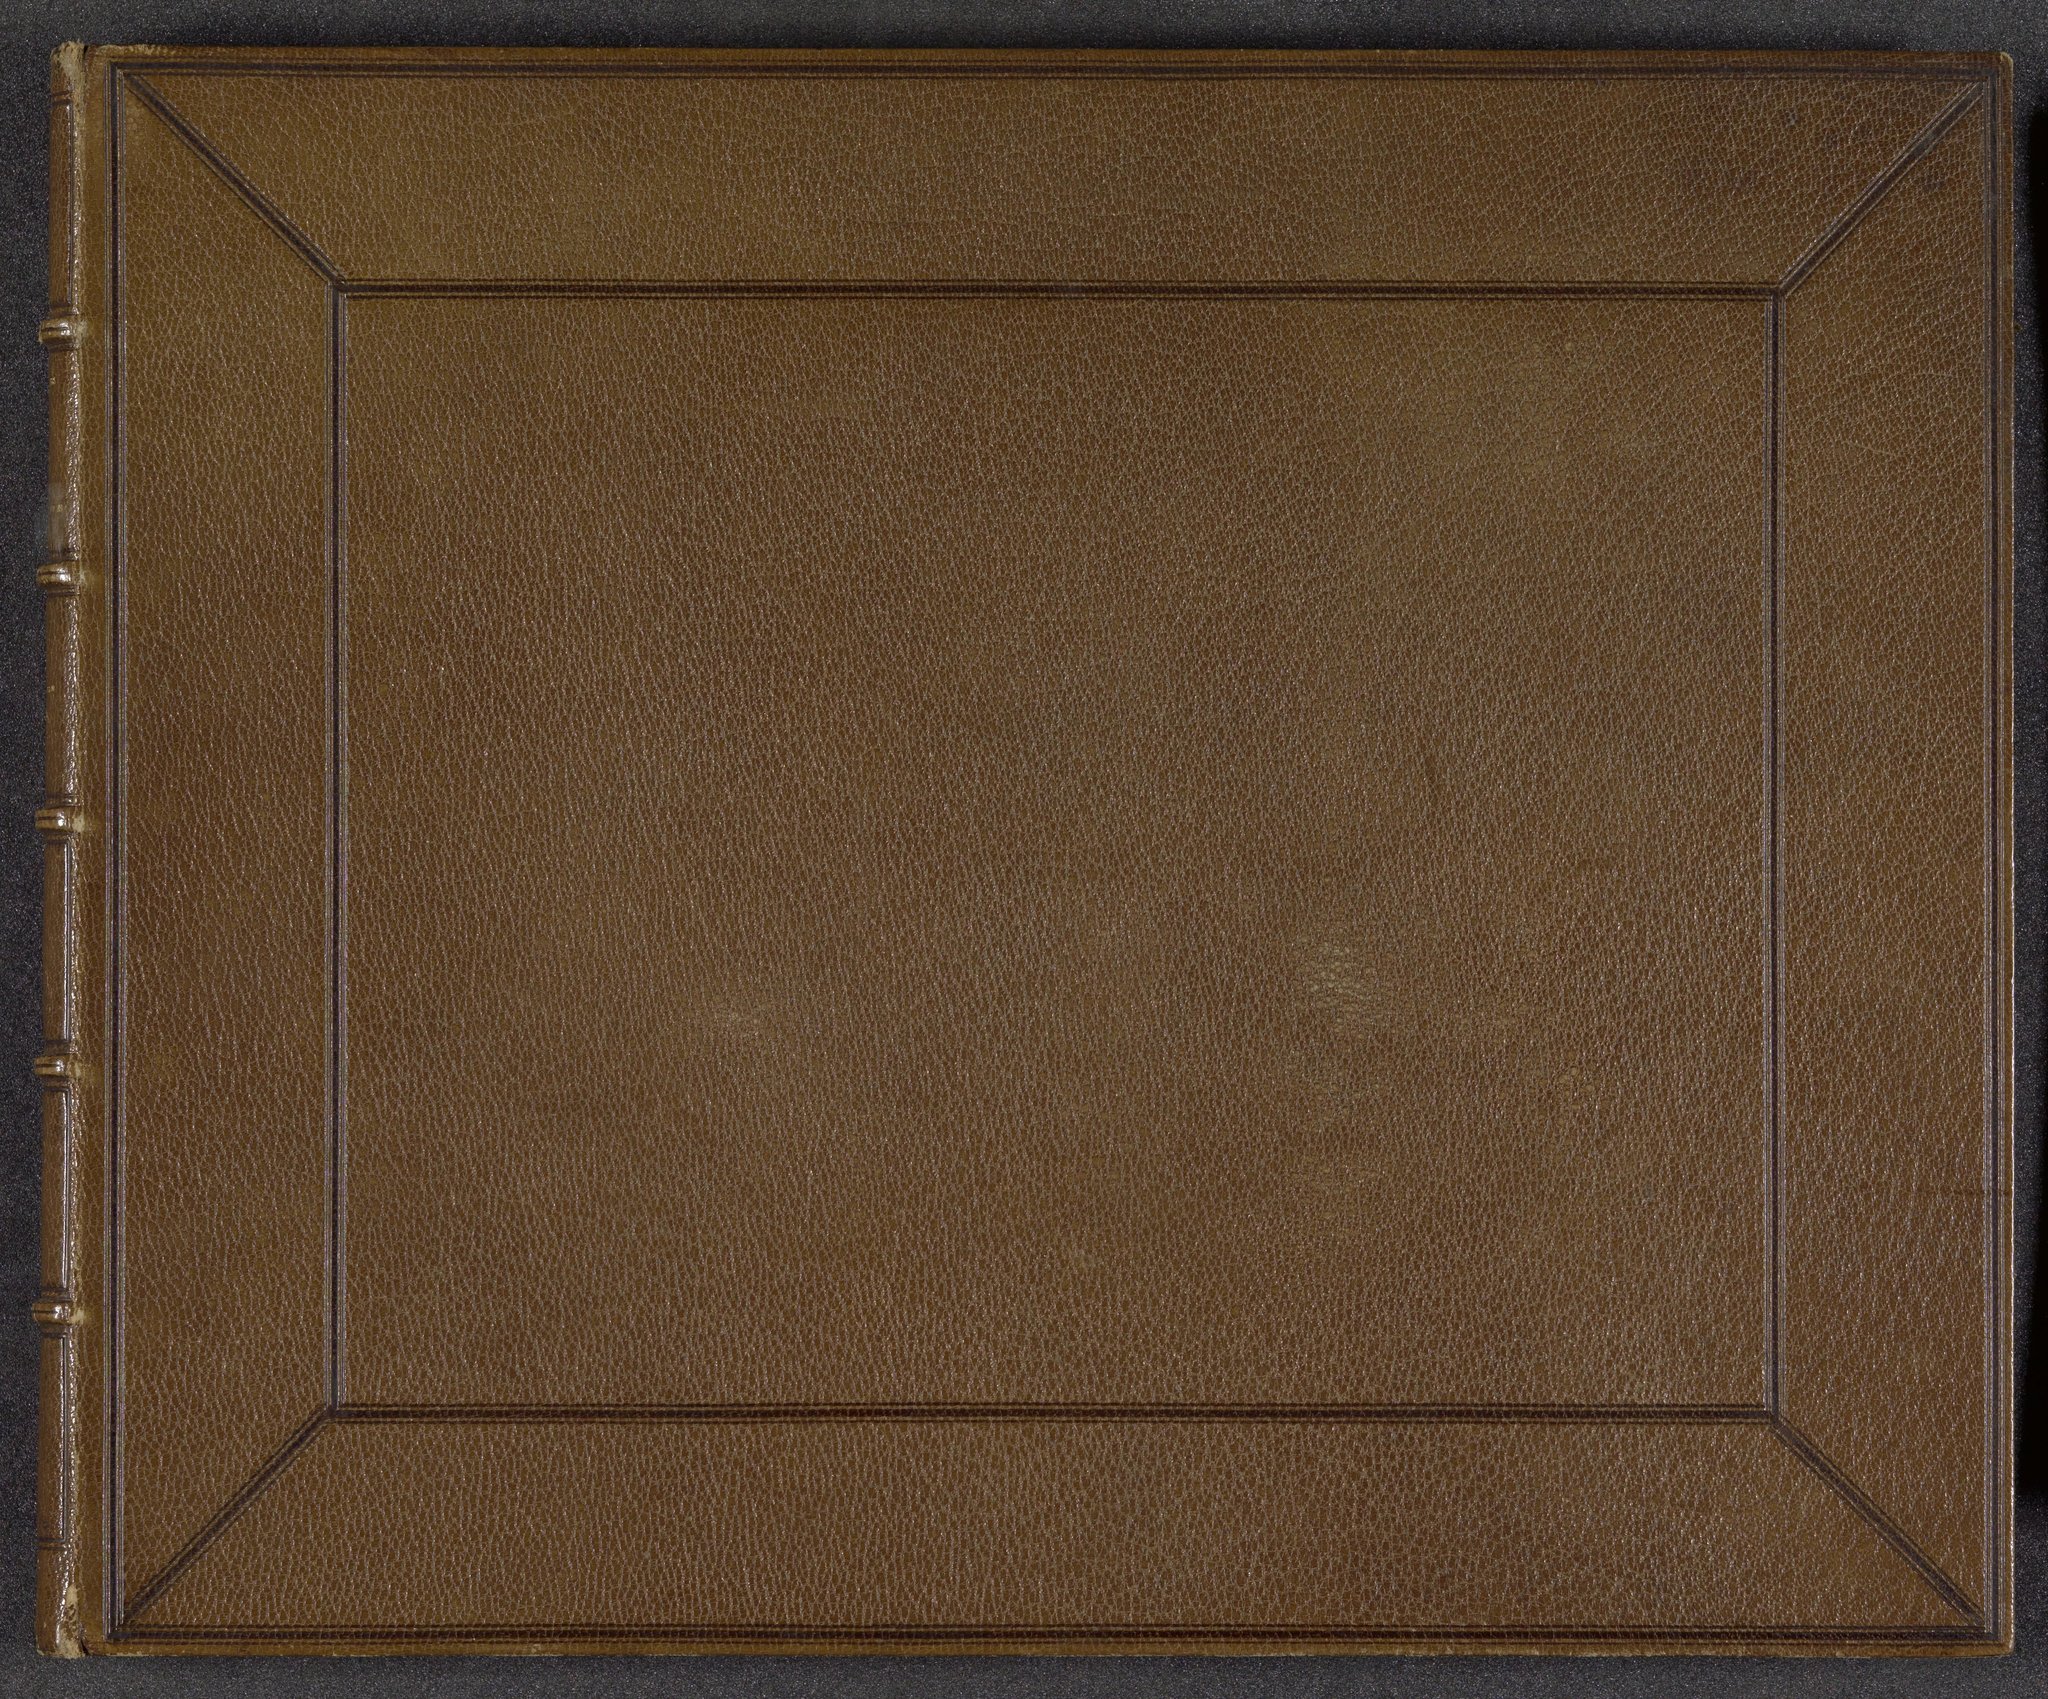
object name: prentrecueil, prentenalbum, prentalbum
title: Album met voorstellingen van fonteinen en architectuurperspectieven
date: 1600-1601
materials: leather, paper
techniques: bookbinding, decorated paper, etching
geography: antwerp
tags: ornamental fountain, civic architecture; edifices; dwellings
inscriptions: label: ‘Legaat Godefroy/ No 800’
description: Album met 47 voorstellingen op 49 albumbladen. Het album bevat de titelprent en 17 afbeeldingen van fonteinen uit de serie getiteld: Artis Perspectivae ... Daarna volgt een serie van 29 voorstellingen met architectuurperspectieven. Bruin marokijnen band, met voorin en achterin twee schutbladen.